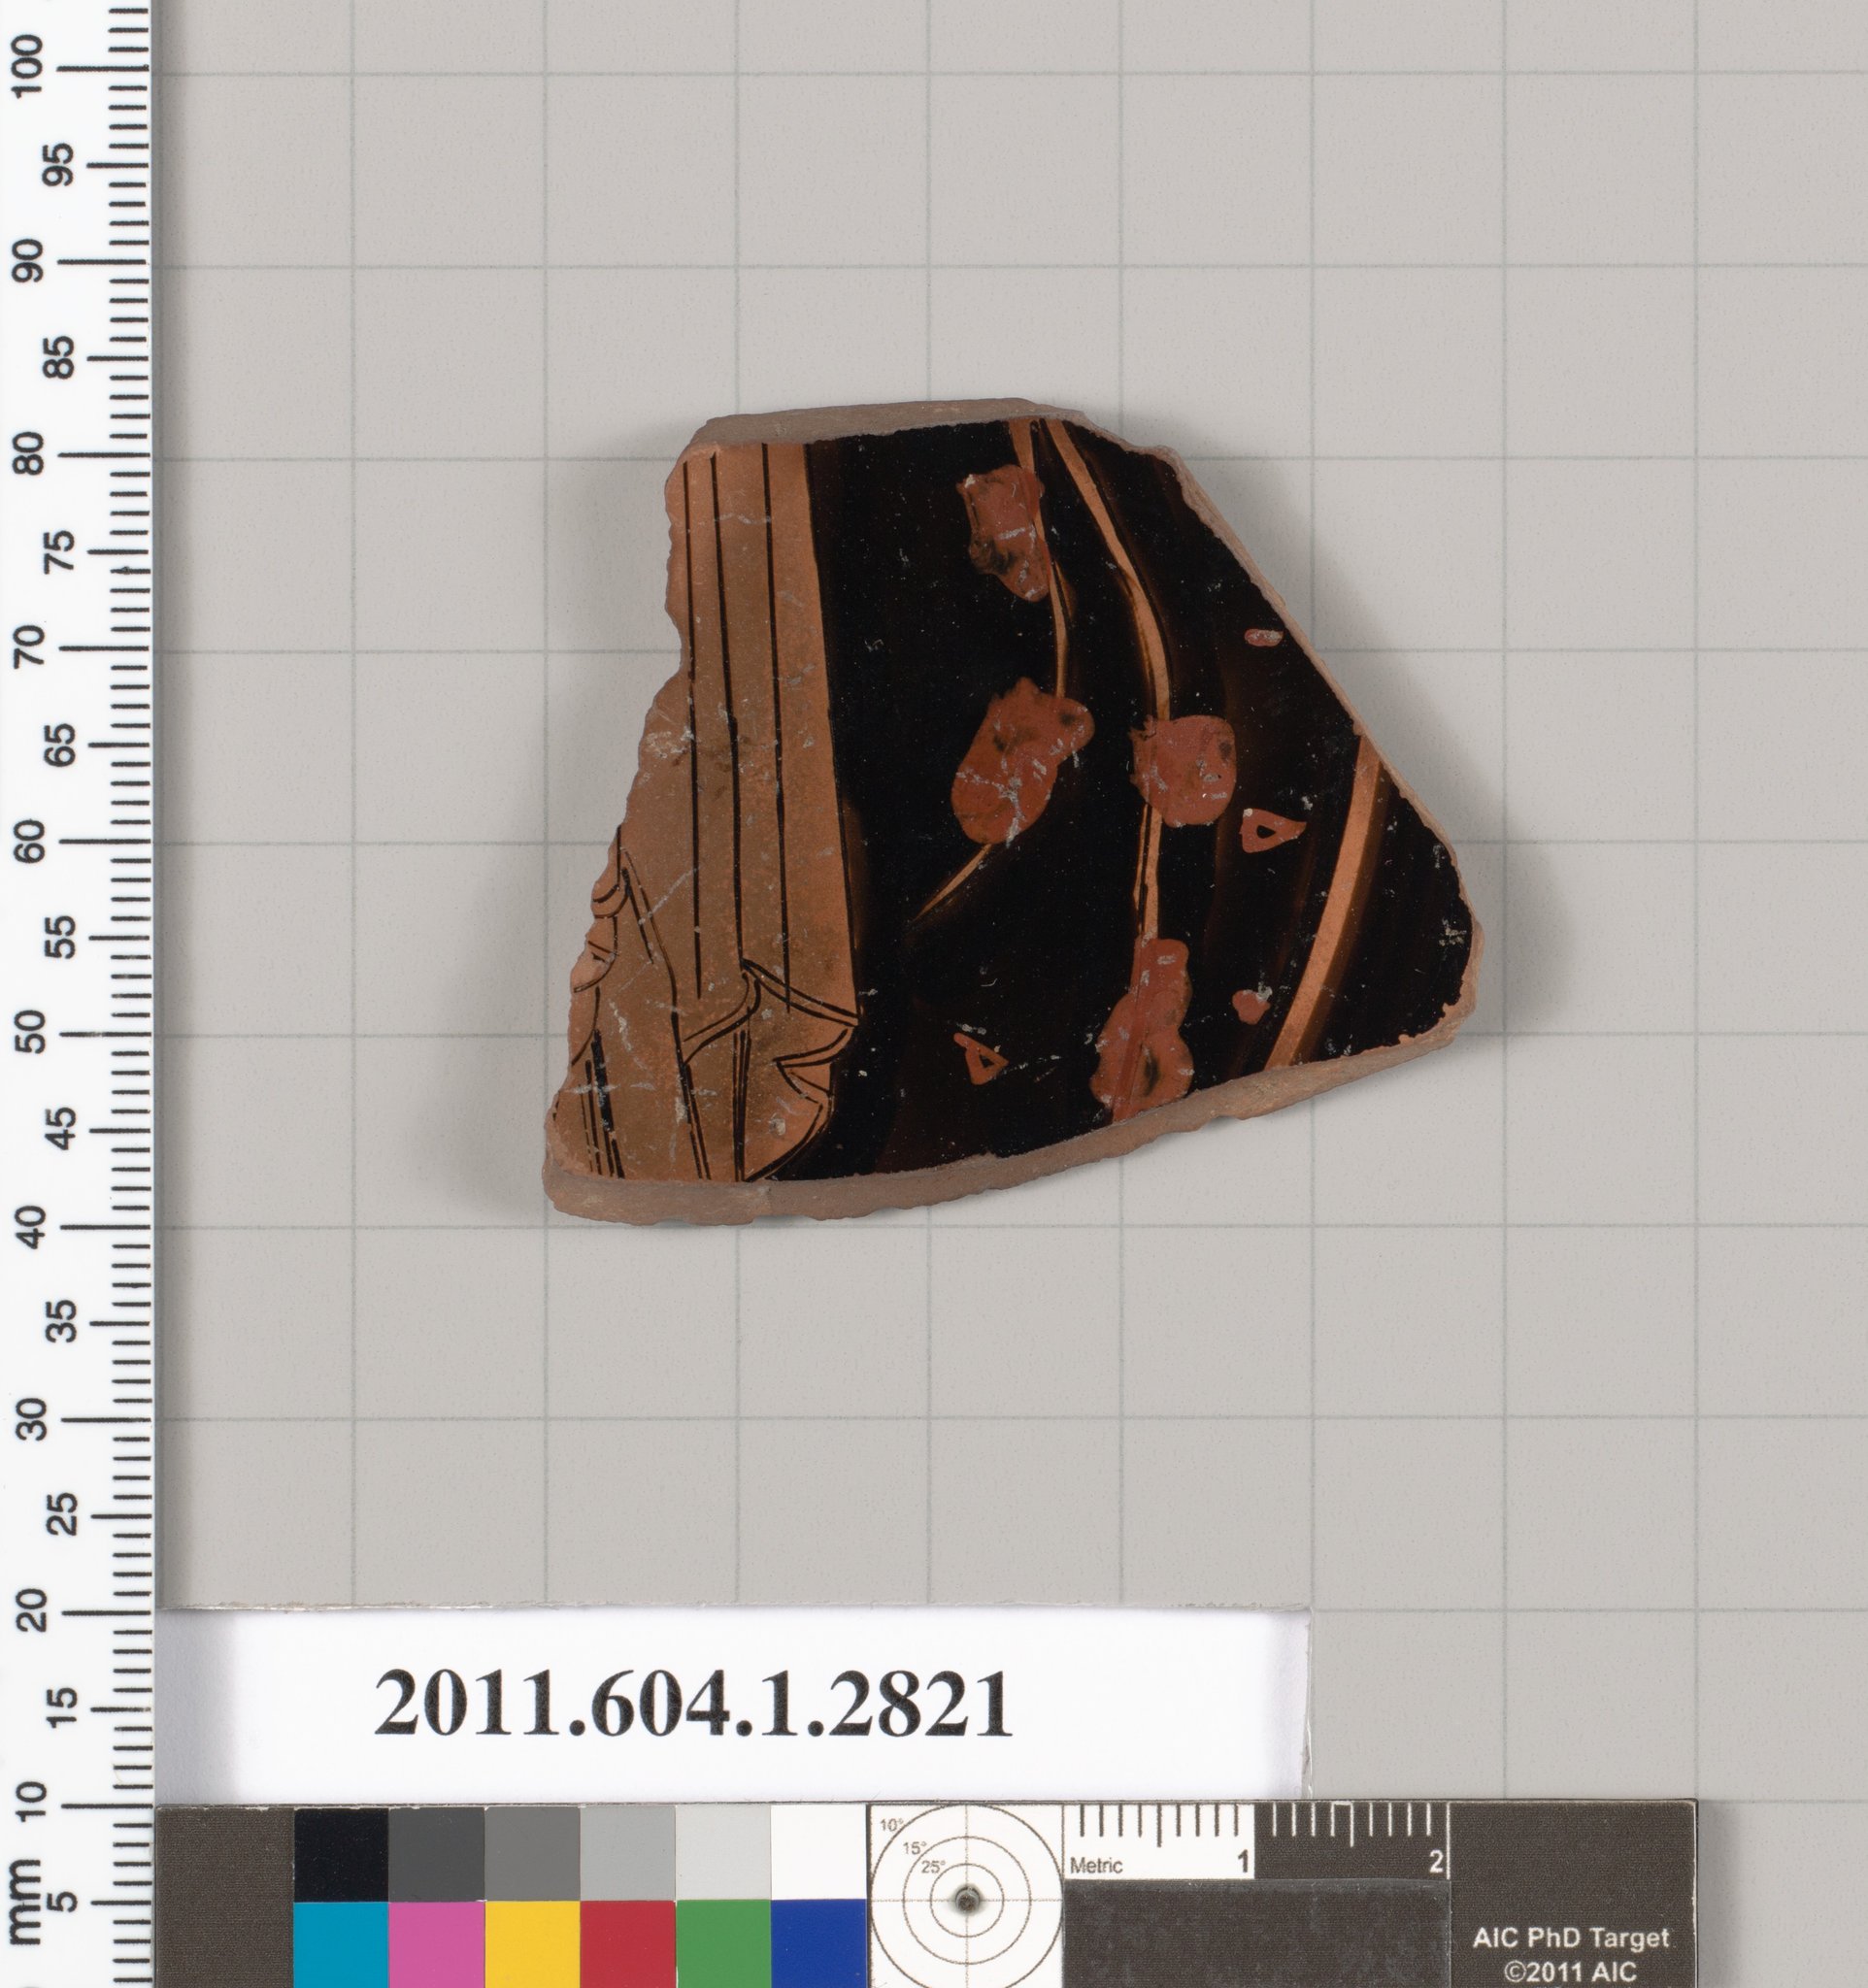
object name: kylix fragment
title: Terracotta fragment of a kylix (drinking cup)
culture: greek, attic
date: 520-500 BCE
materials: terracotta